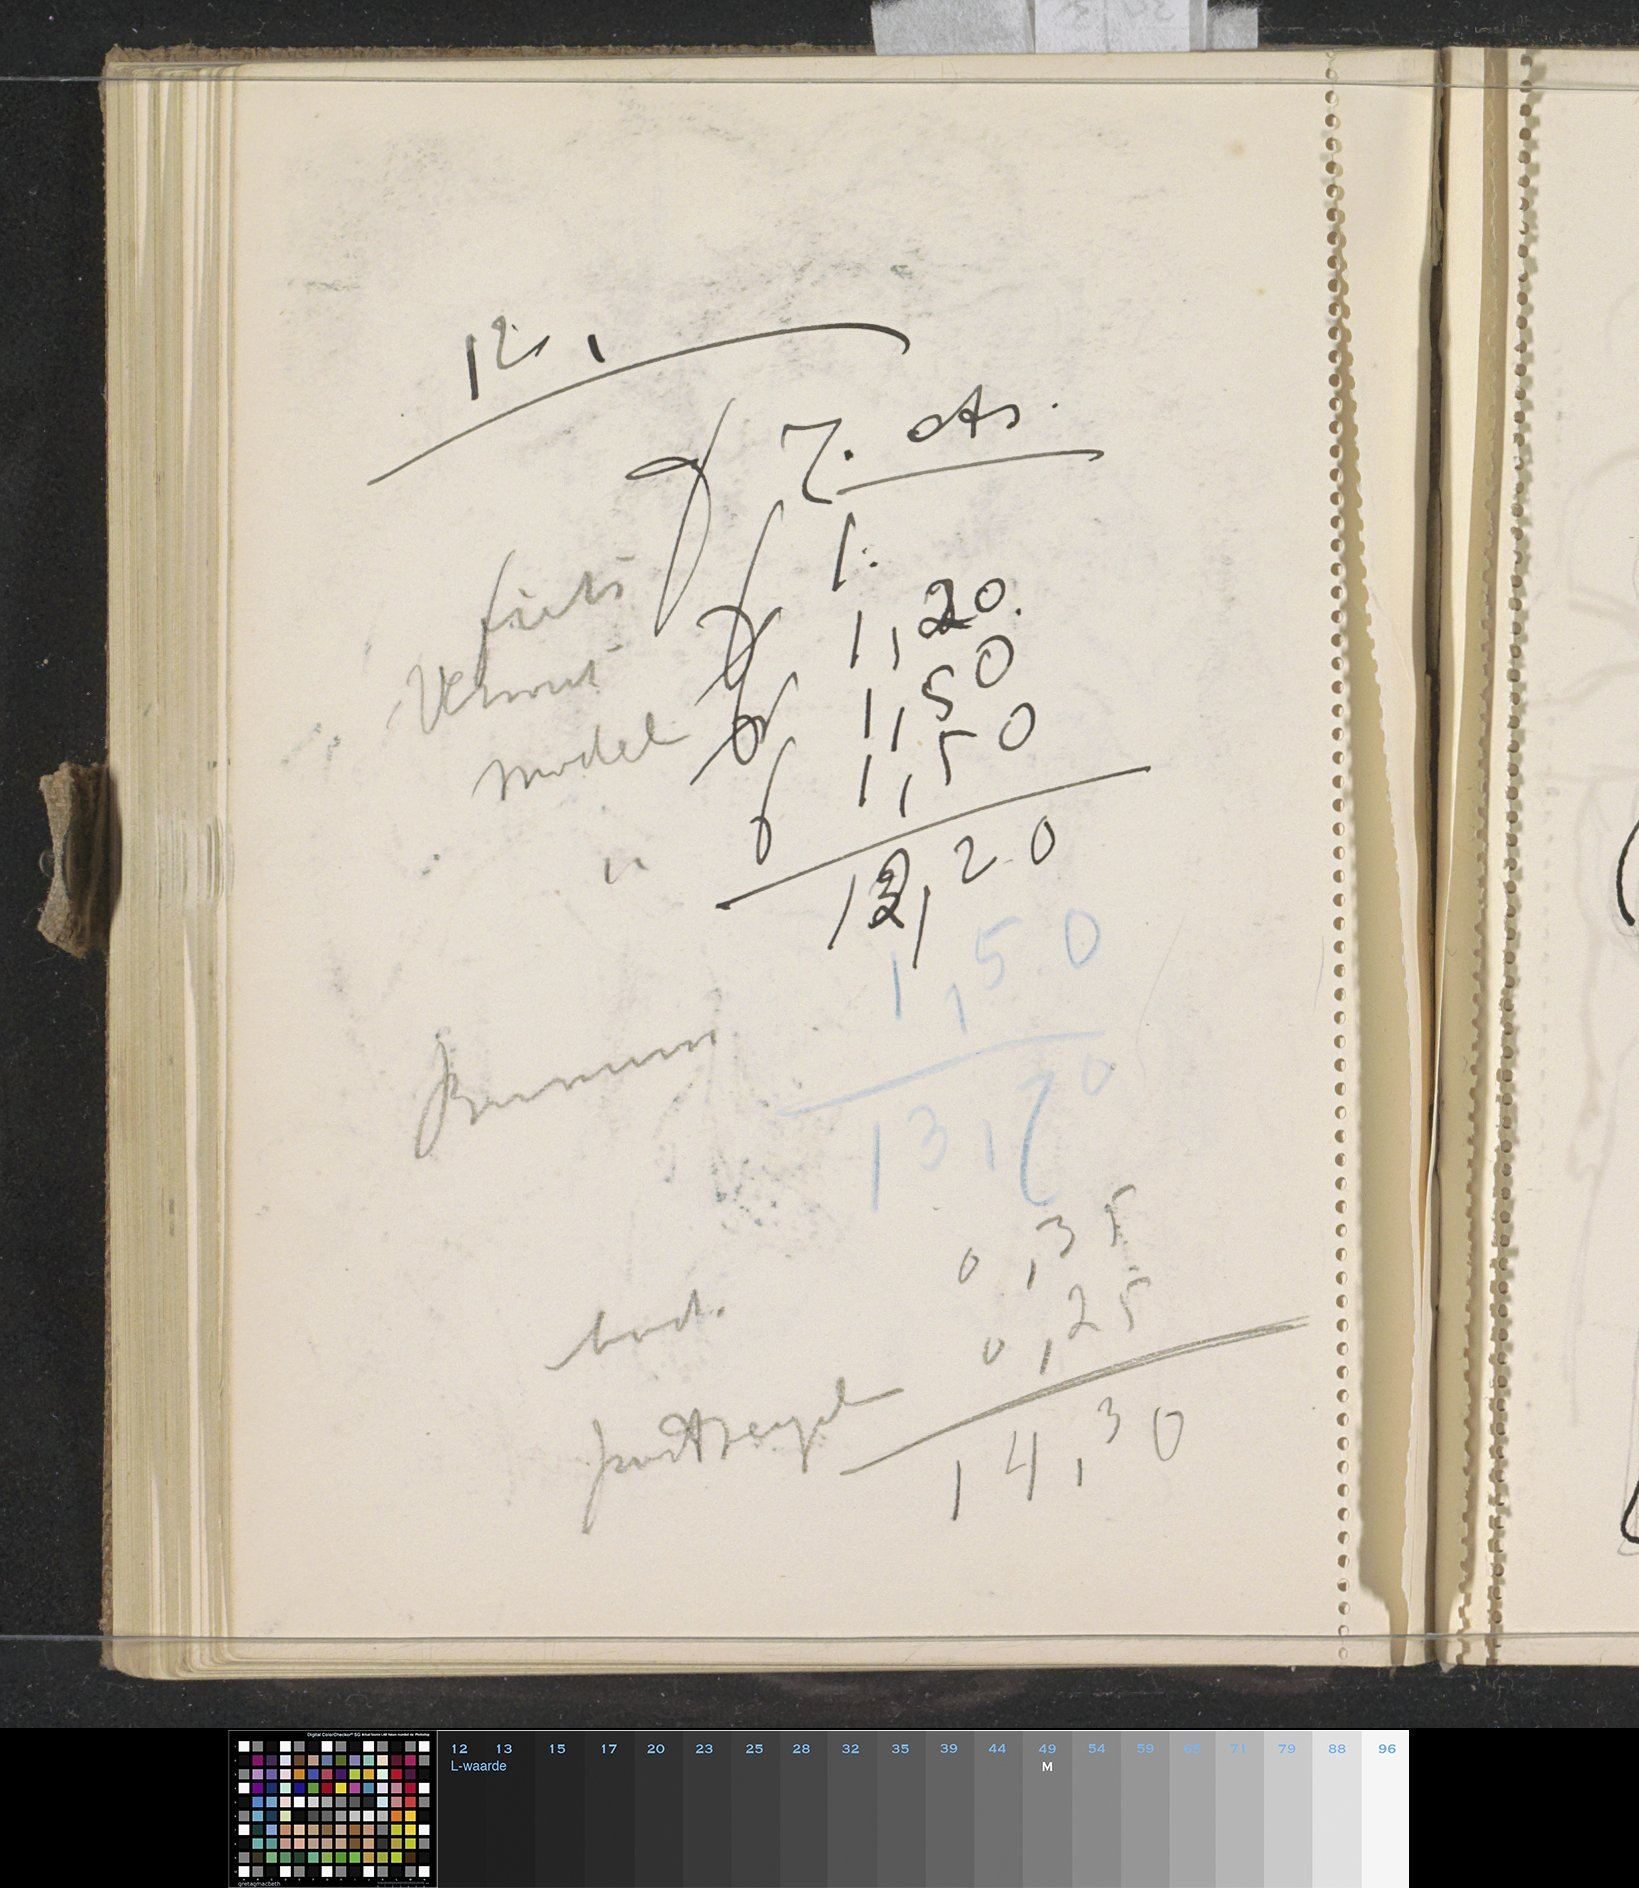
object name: sketchbook leaf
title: Berekeningen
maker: reijer stolk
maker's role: draughtsman, print maker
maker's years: 1896-1945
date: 1906-1945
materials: ink, paper, pencil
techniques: pen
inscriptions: annotation: ‘[...]’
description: Blad 39 verso uit een schetsboek met 42 bladen.